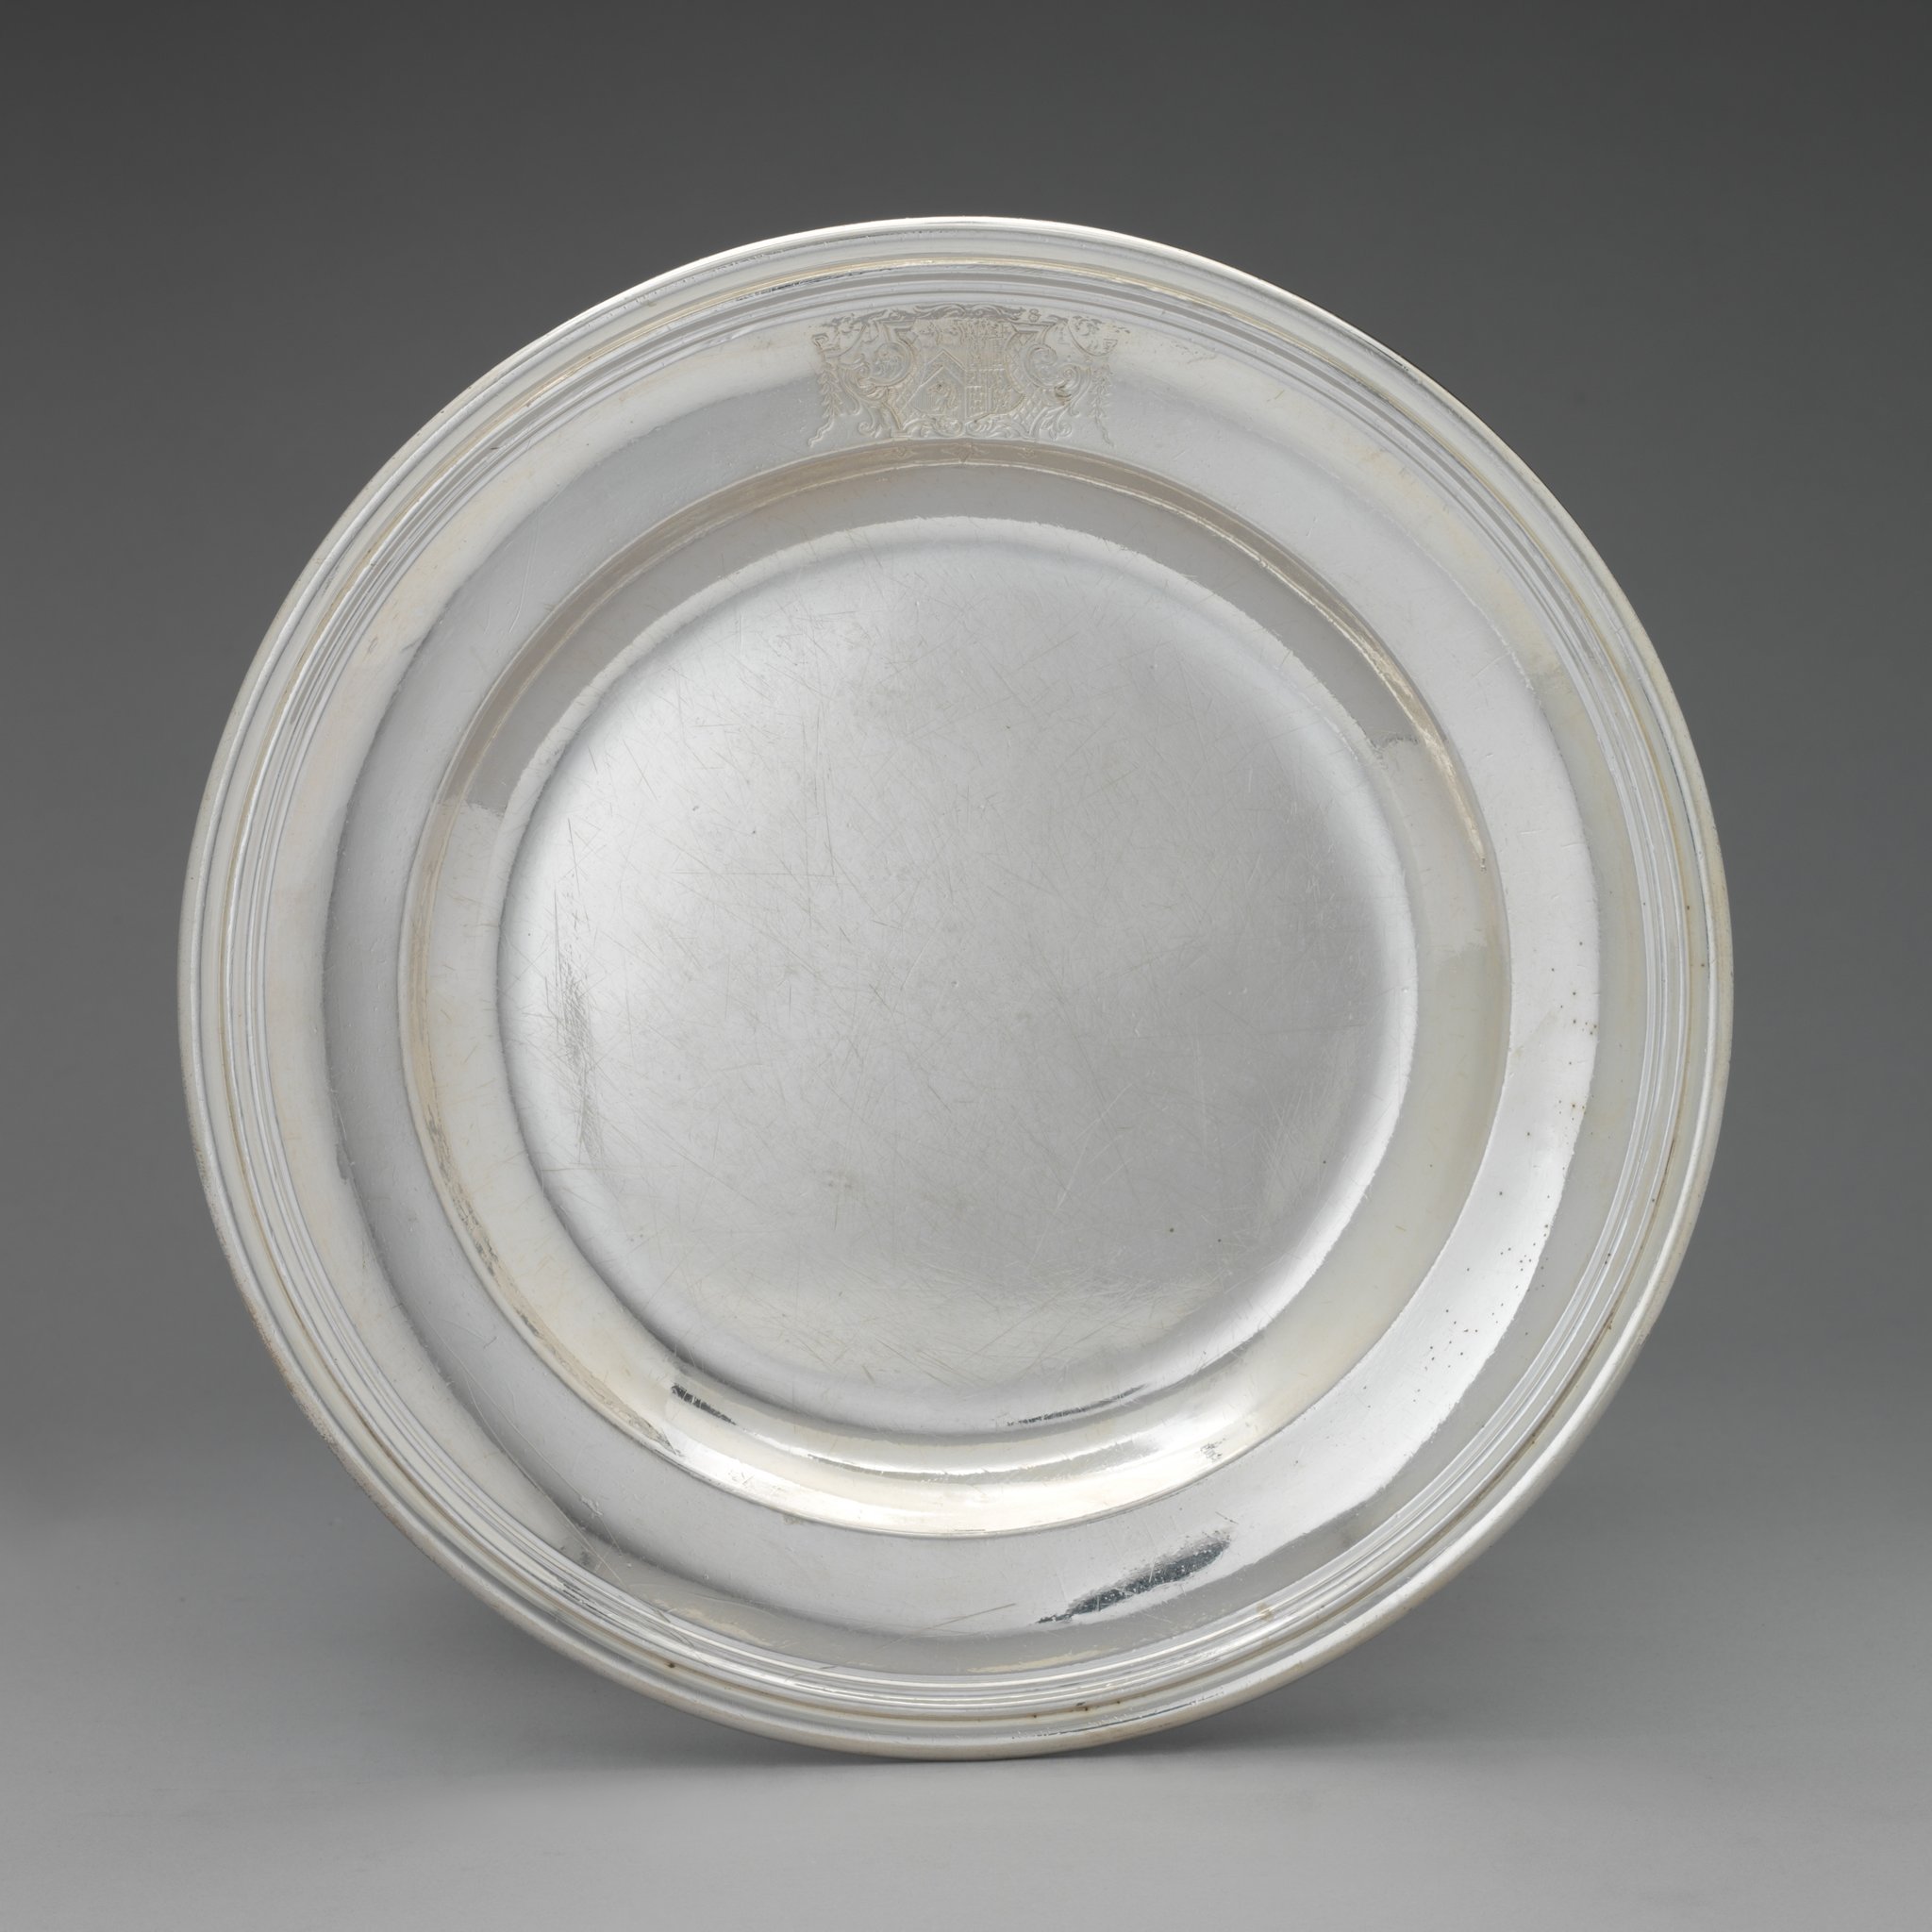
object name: plate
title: Plate (one of a set of twelve)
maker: thomas farren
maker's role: maker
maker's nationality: british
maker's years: 1703-1743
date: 1715-1716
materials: silver